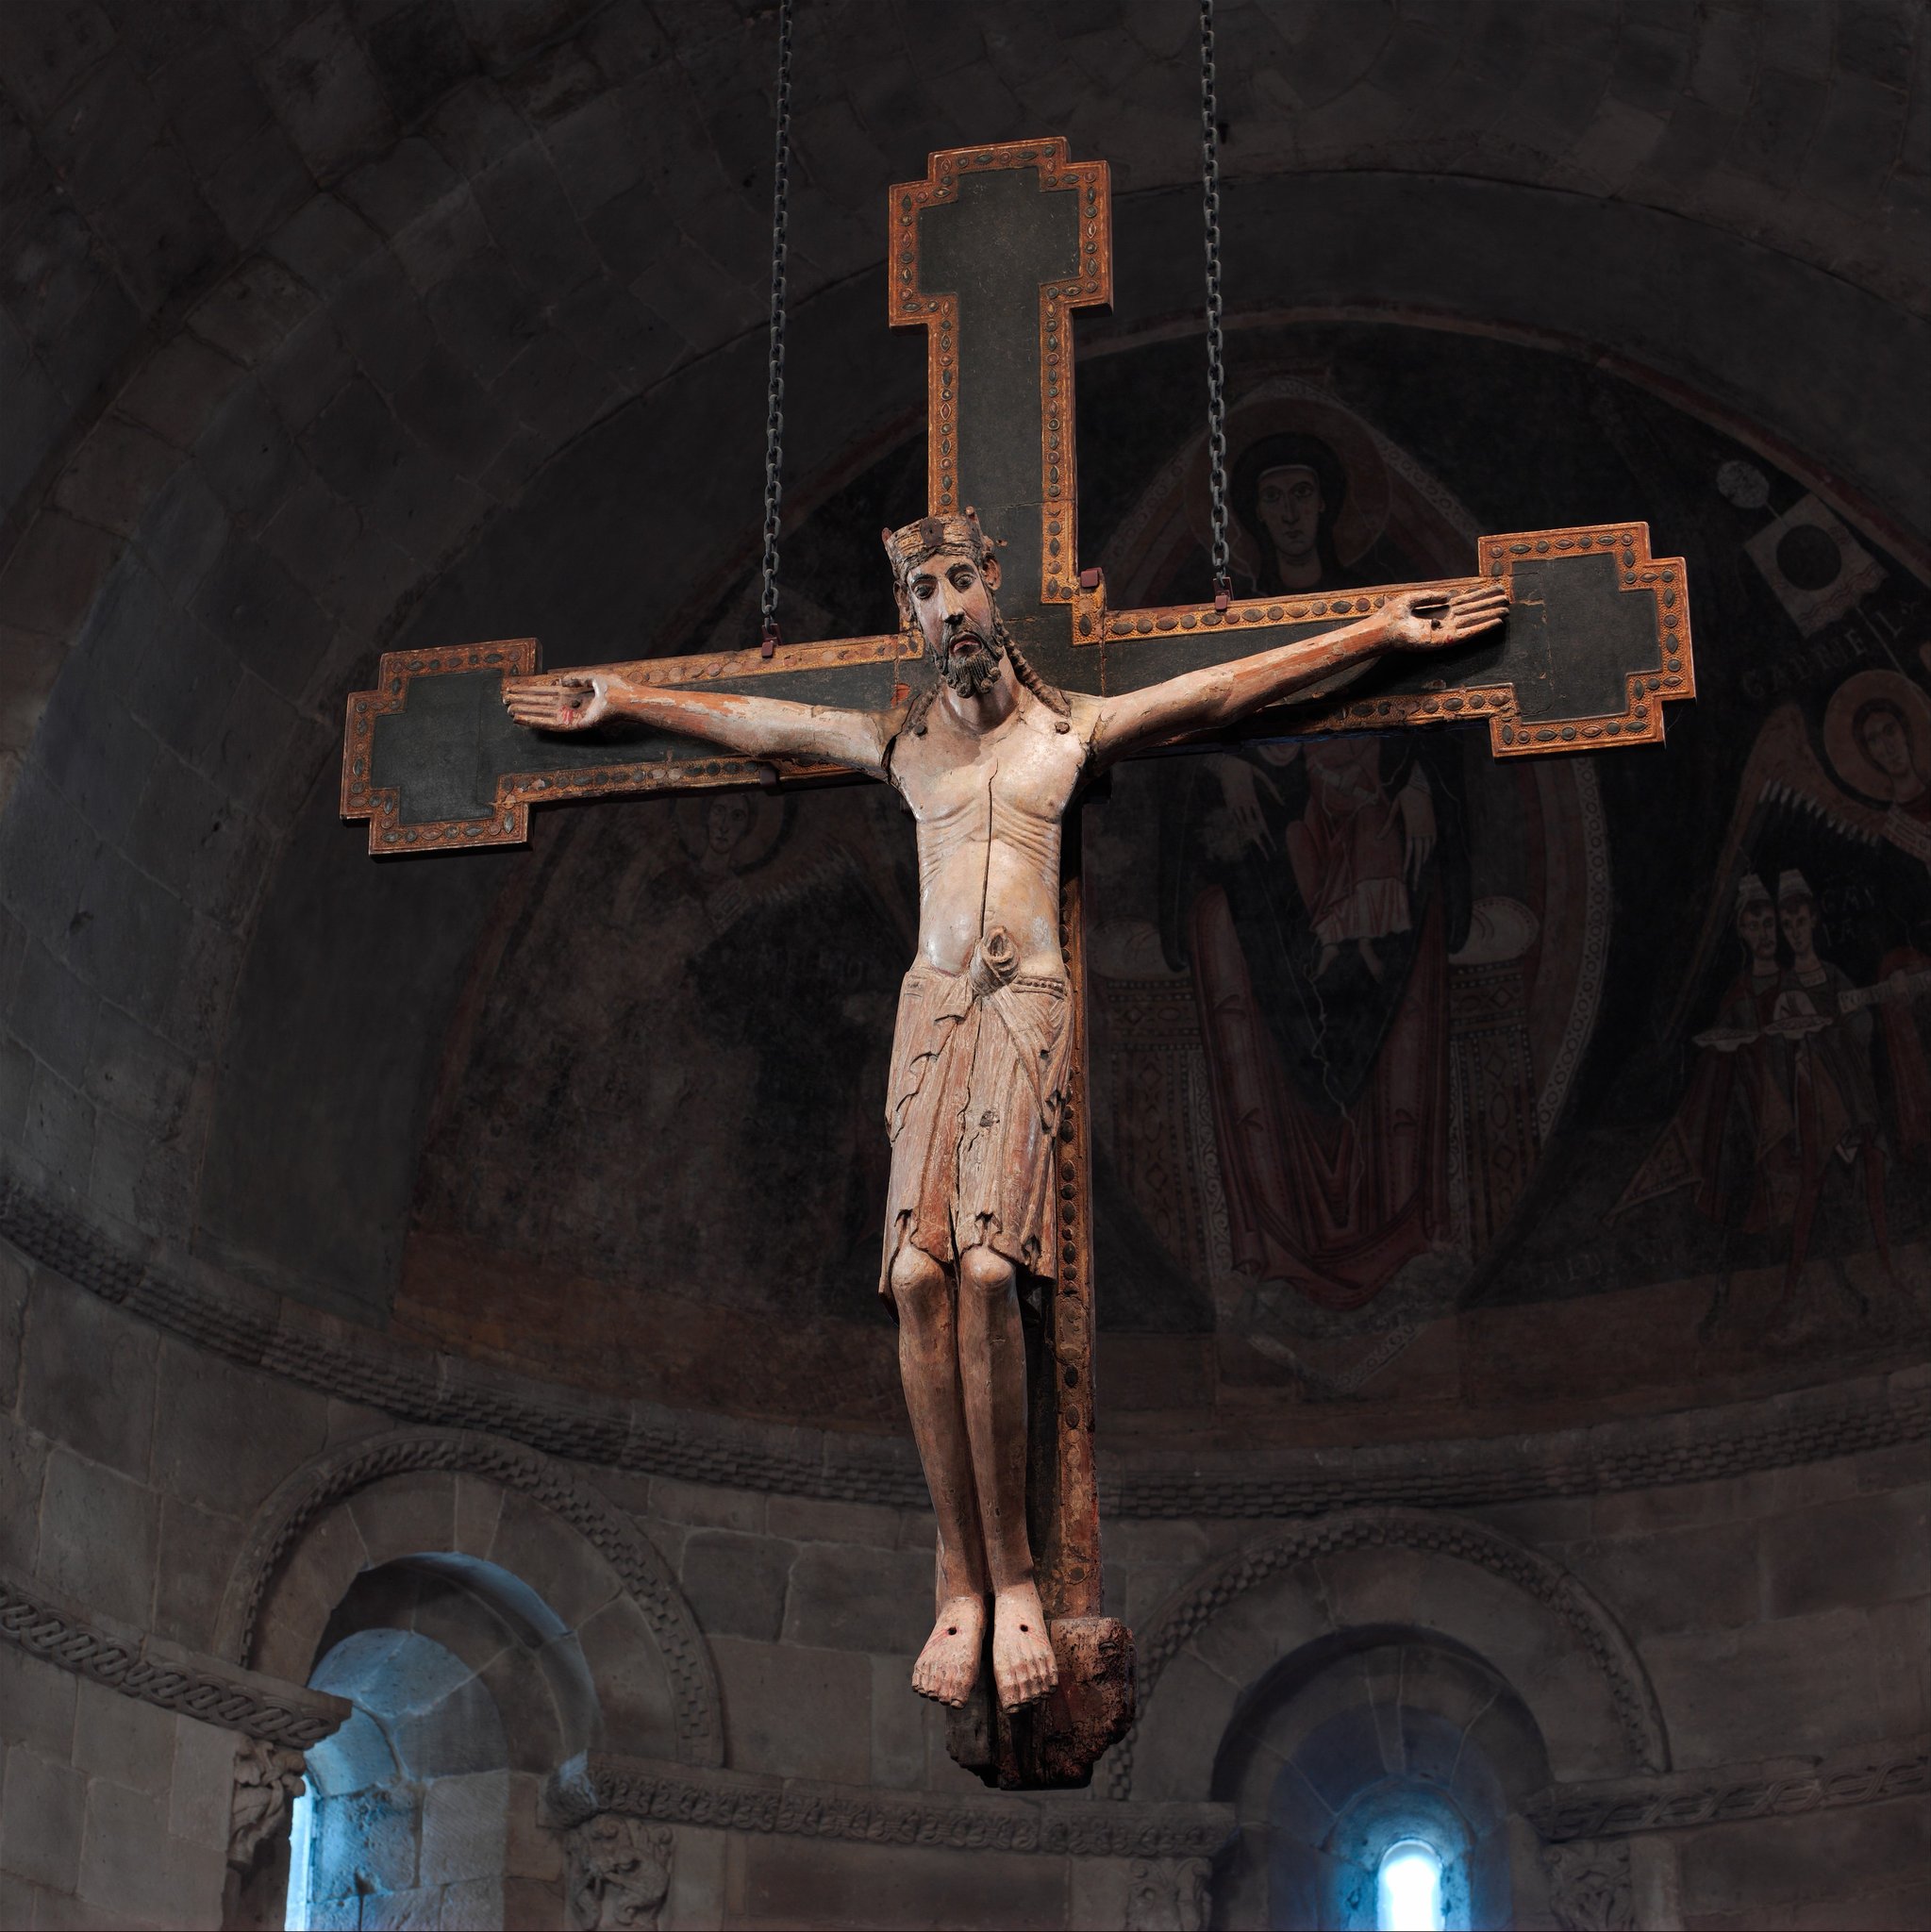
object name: crucifix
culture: spanish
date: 1150-1200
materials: gold leaf, wood, paint, tin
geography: spain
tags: christ,cross,crucifixion